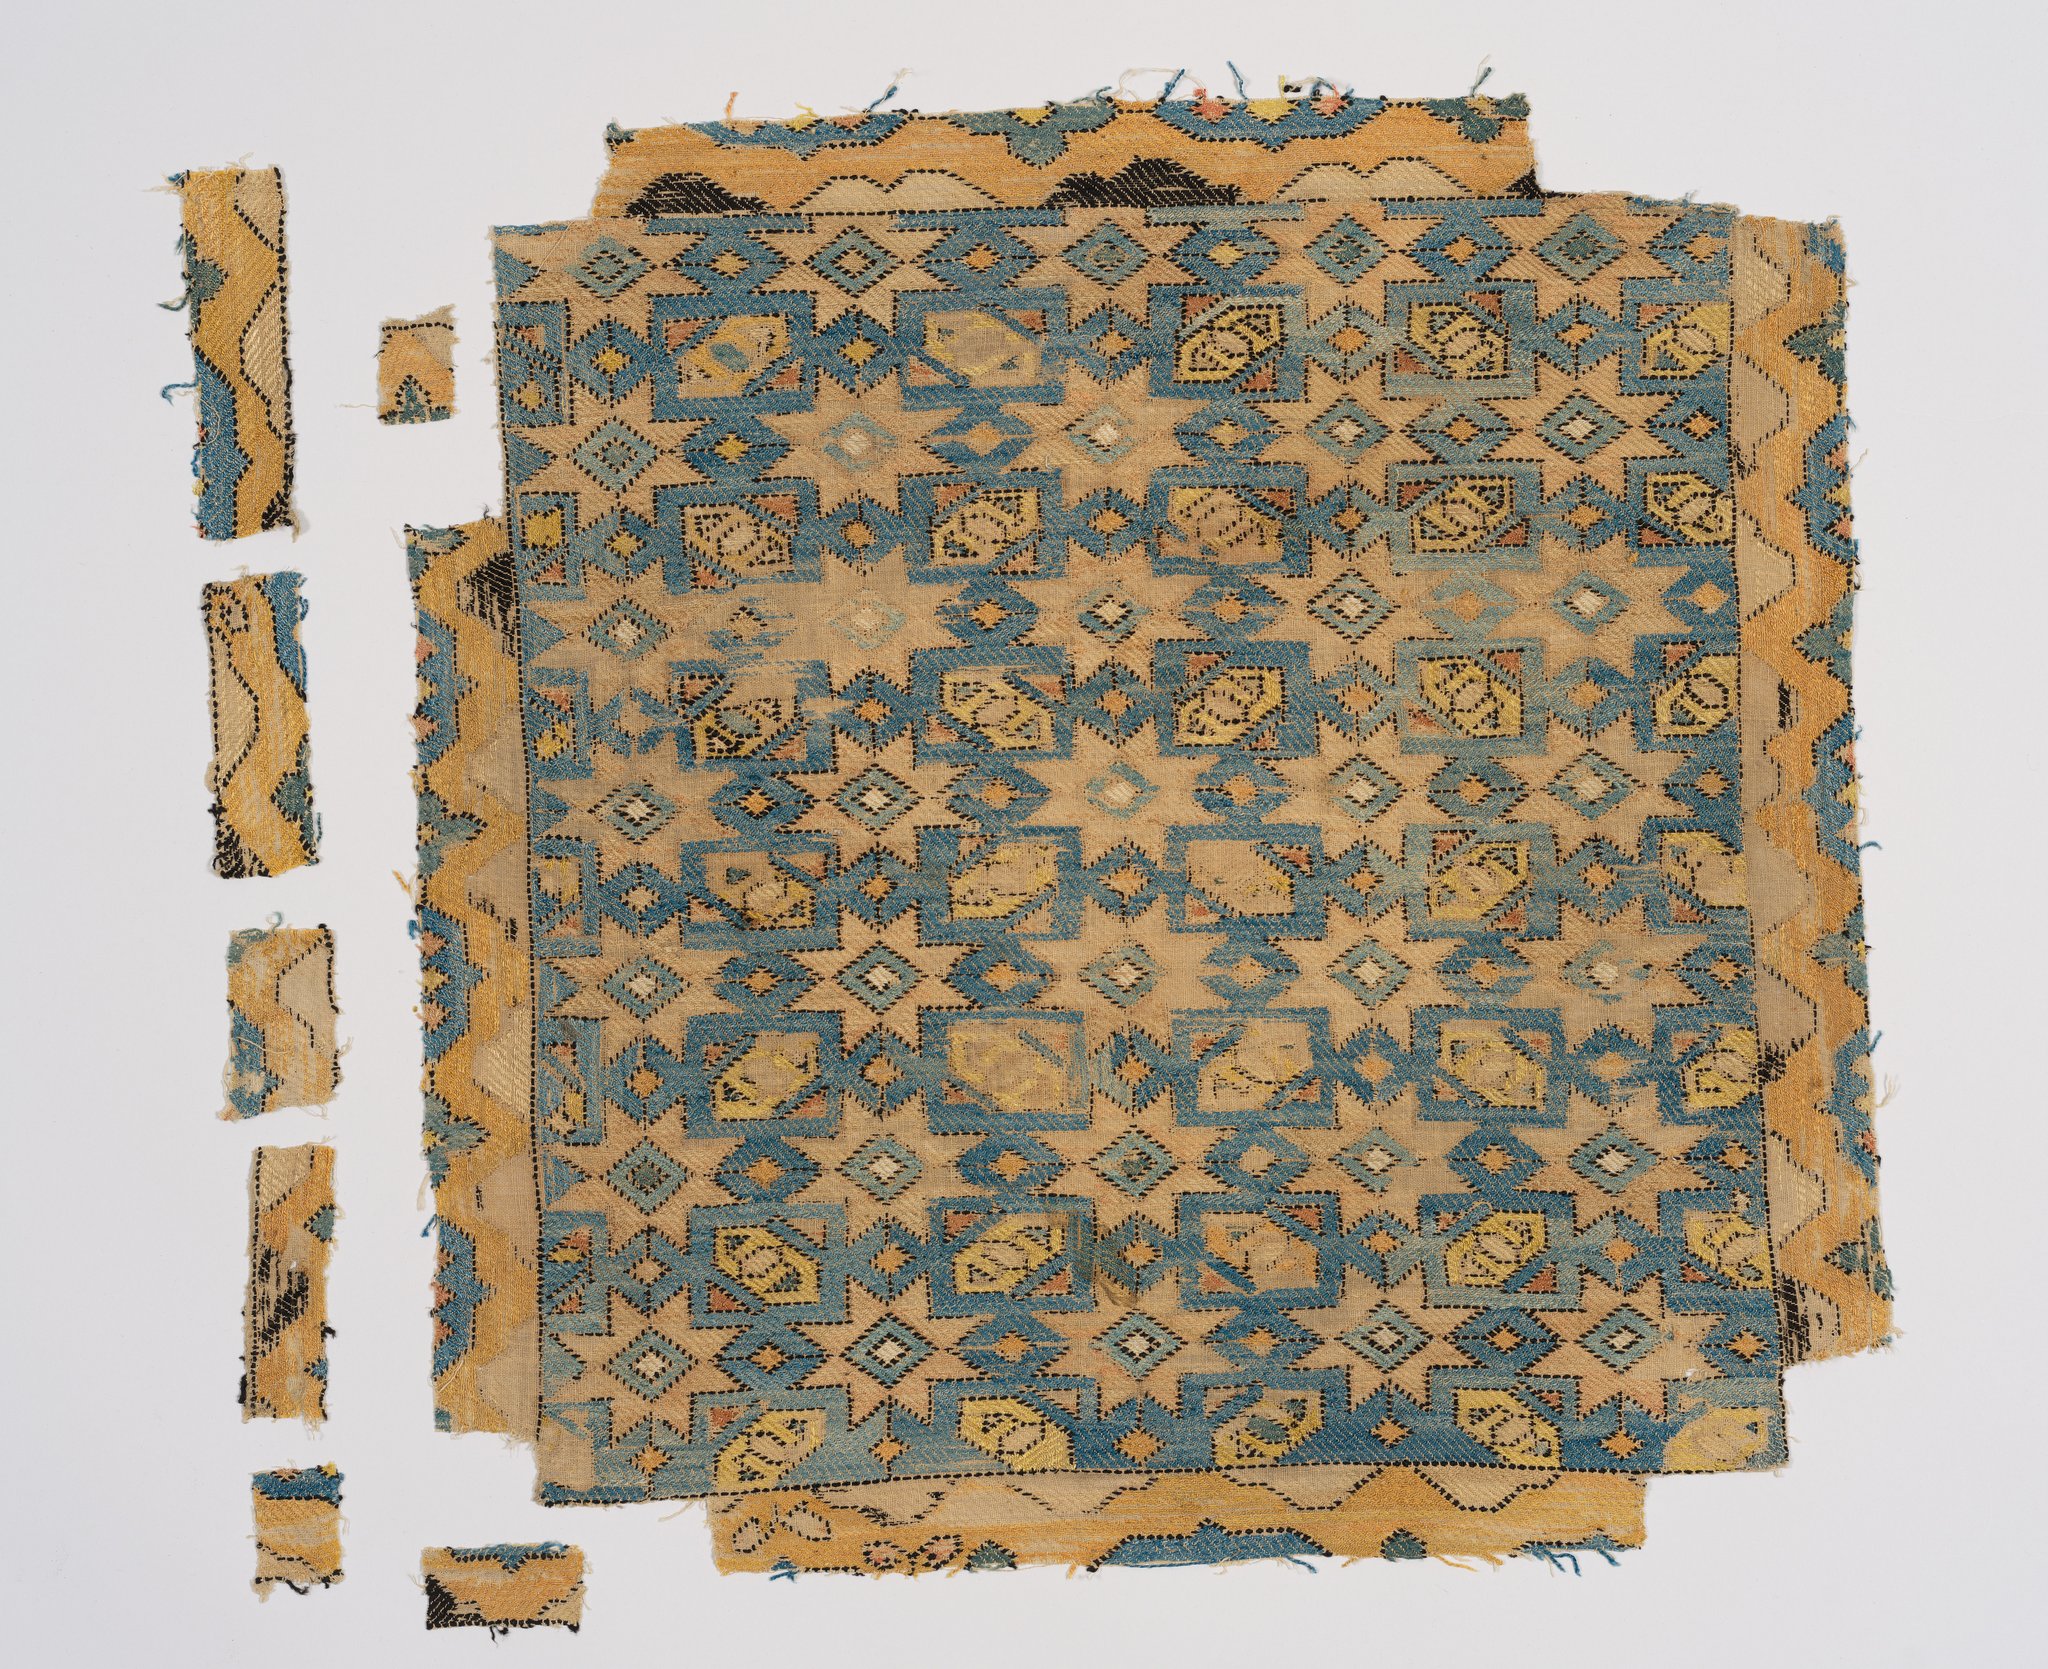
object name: cover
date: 1701-1800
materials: linen, silk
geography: caucasus